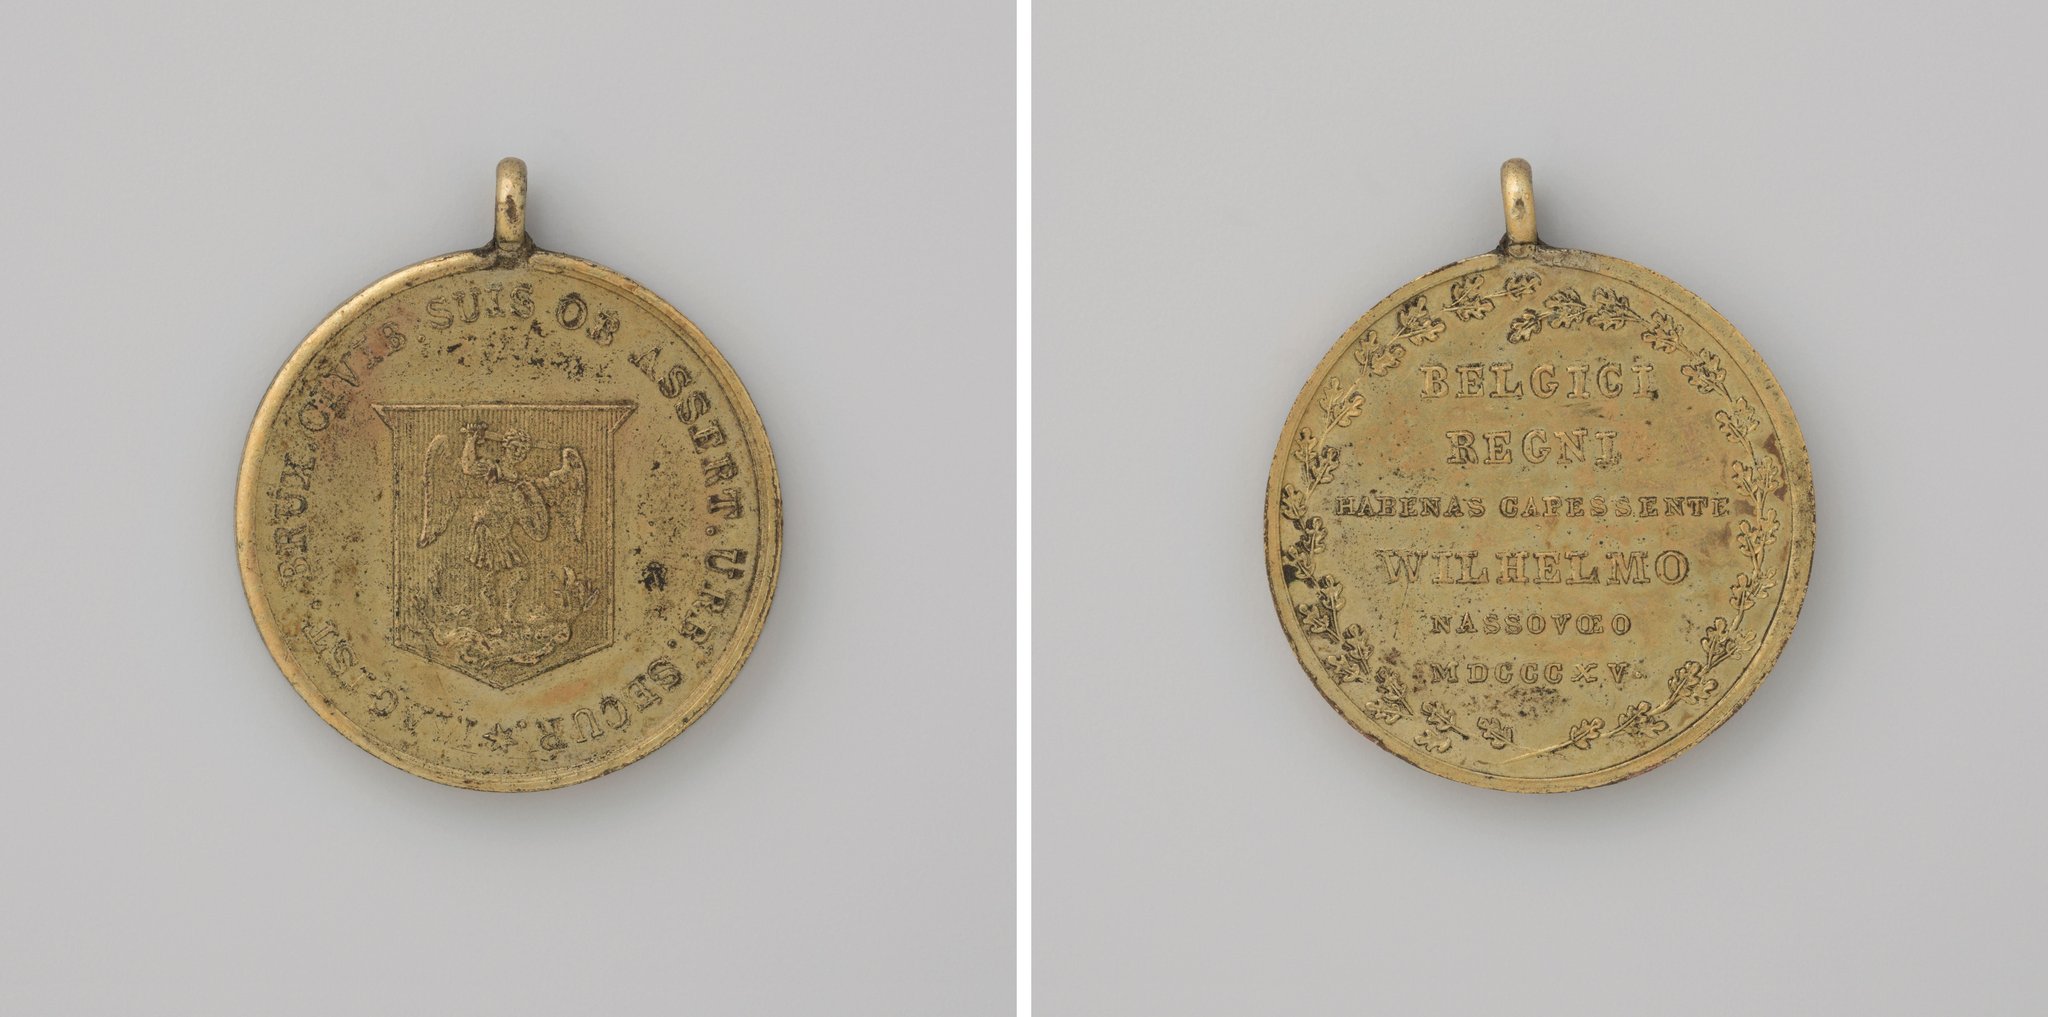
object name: honorary medal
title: Verdediging van Brussel, penning door de stad uitgereikt aan de gewapende burgerij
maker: Anonymous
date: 1815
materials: copper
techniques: striking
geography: brussels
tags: the hague, berlin, william i of the netherlands, brussels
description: Koperen penning aan draagring. Voorzijde: wapenschild binnen omschrift. Keerzijde: opschrift binnen eikekrans